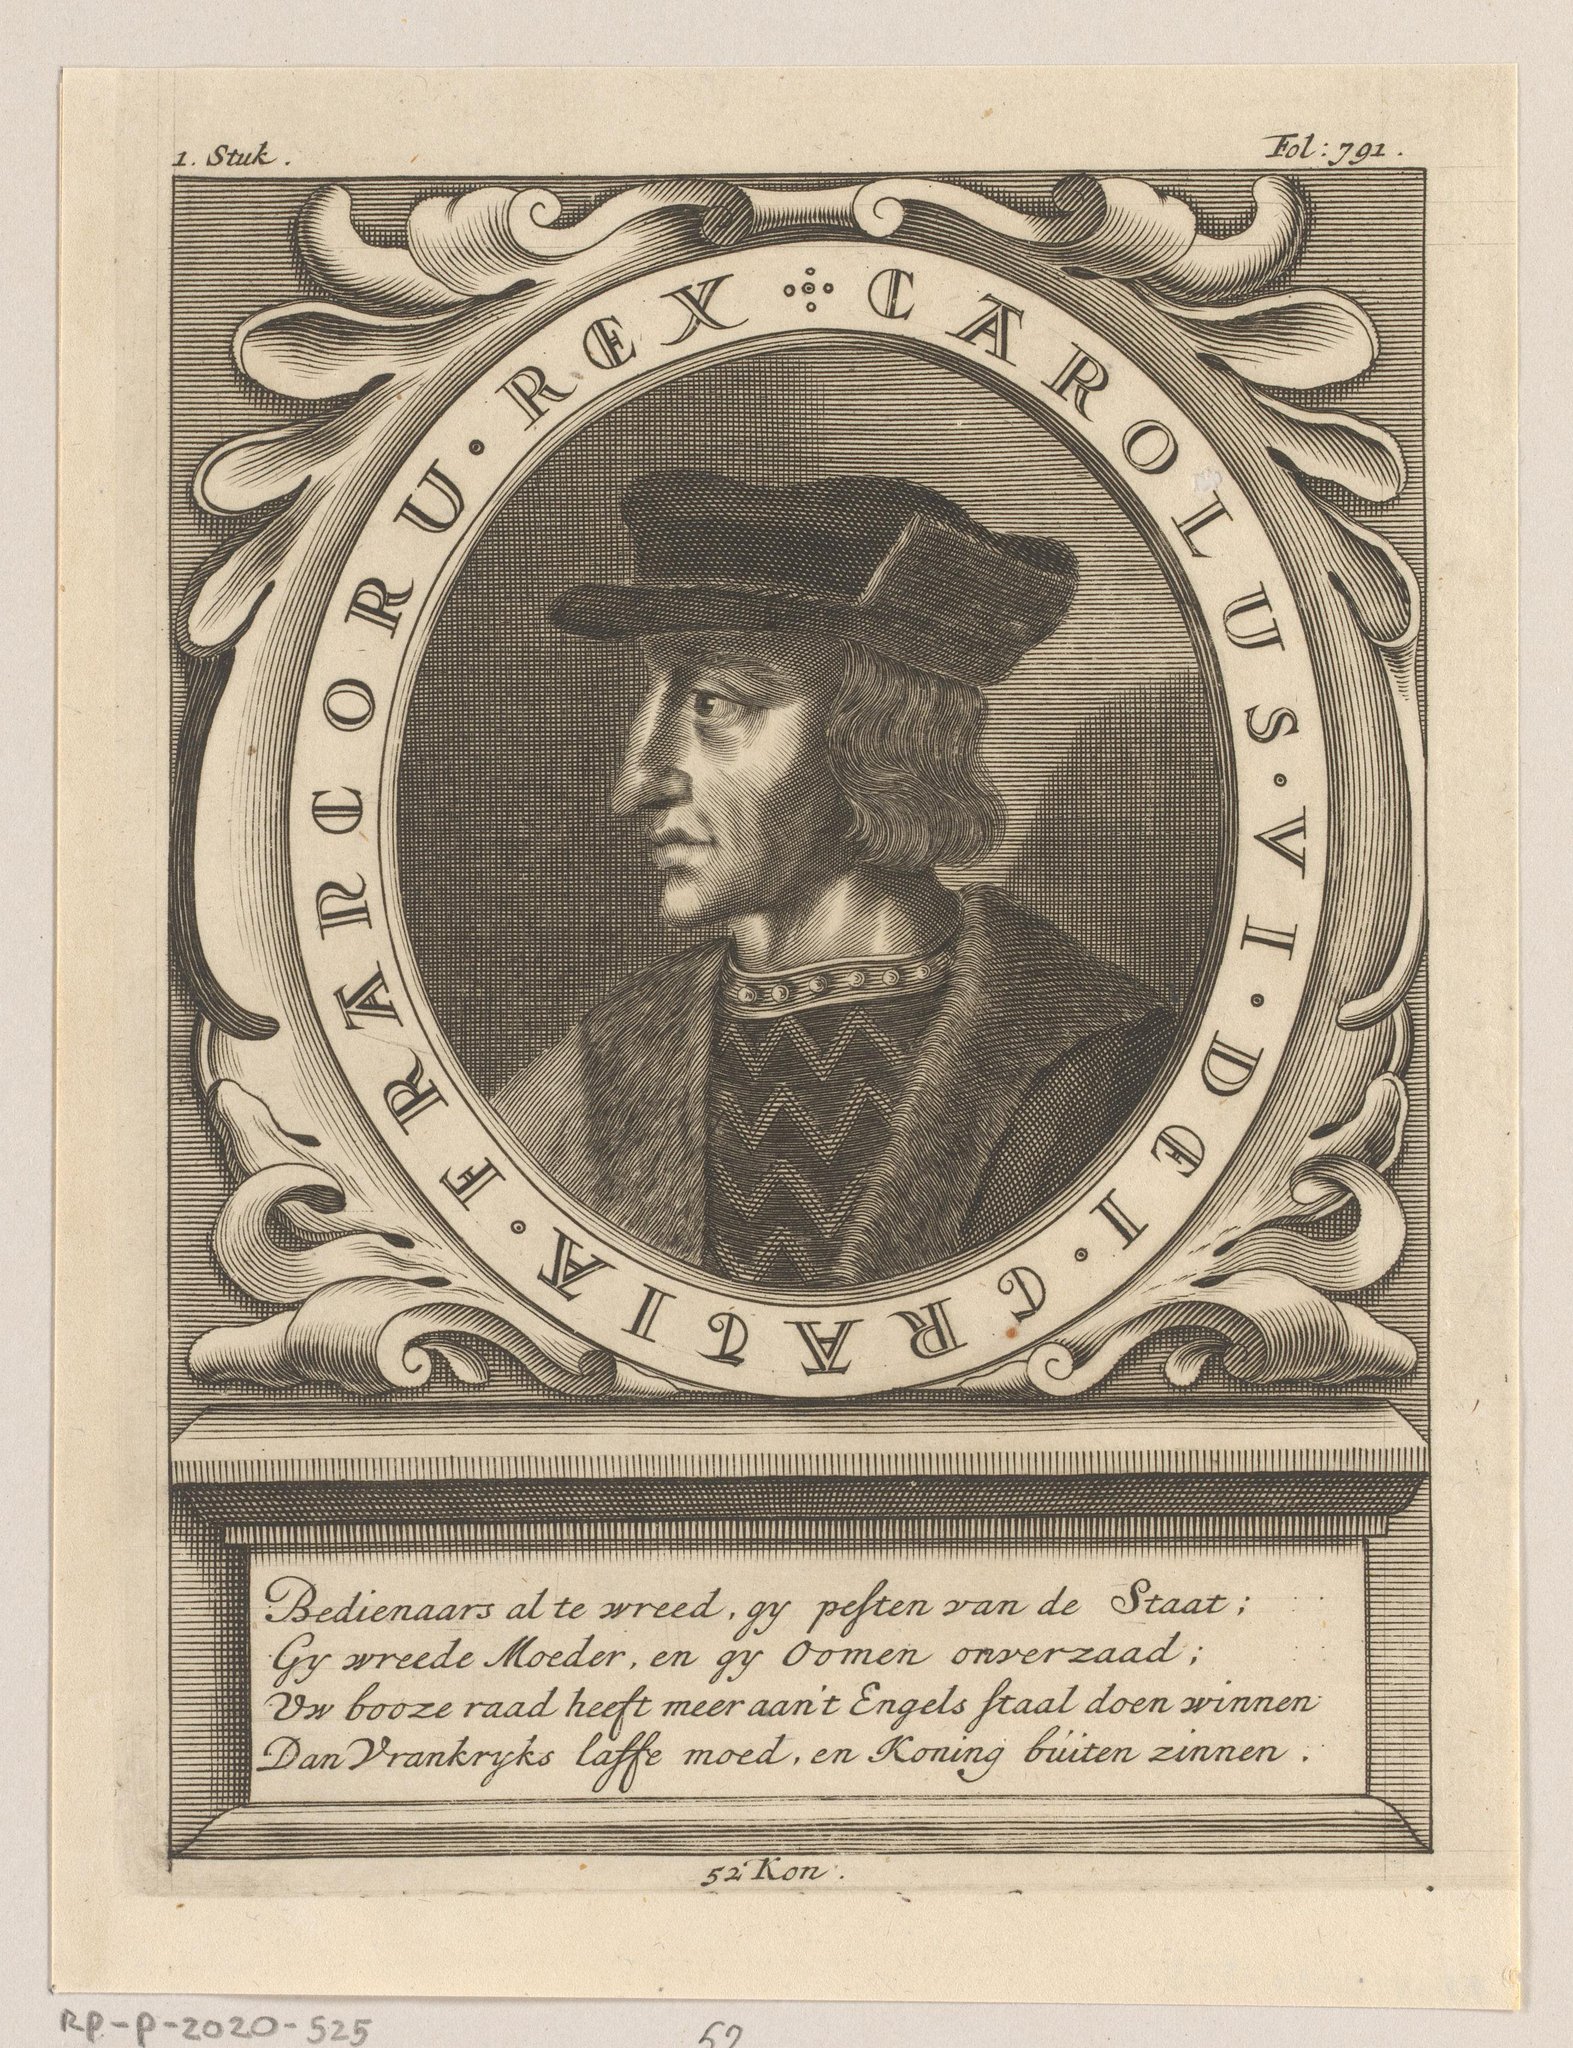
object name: book illustration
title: Carolus VI dei gratia Francoru rex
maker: Anonymous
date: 1685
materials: paper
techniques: engraving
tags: paris, historical persons, king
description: Prent gebruikt in: Eudes de Mézeray, François. Chronyk van Vrankryk. 6 dln. Amsterdam: Jan Bouman en Timotheum ten Hoorn, 1685, dl. 3.